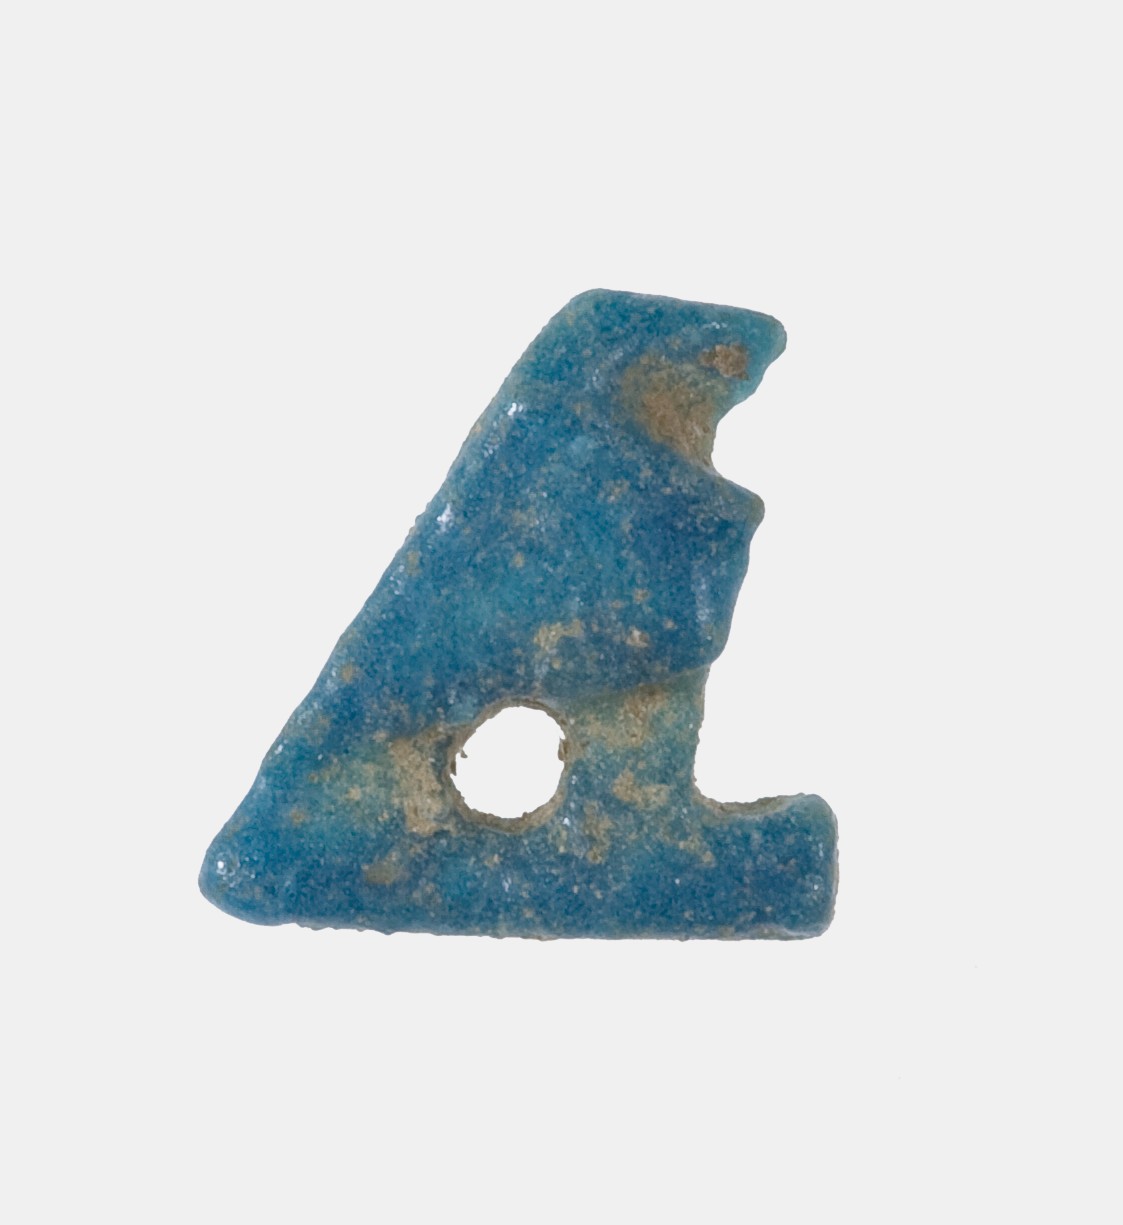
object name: amulet, falcon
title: Falcon Amulet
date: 1802-1450 BCE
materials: faience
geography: egypt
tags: falcons